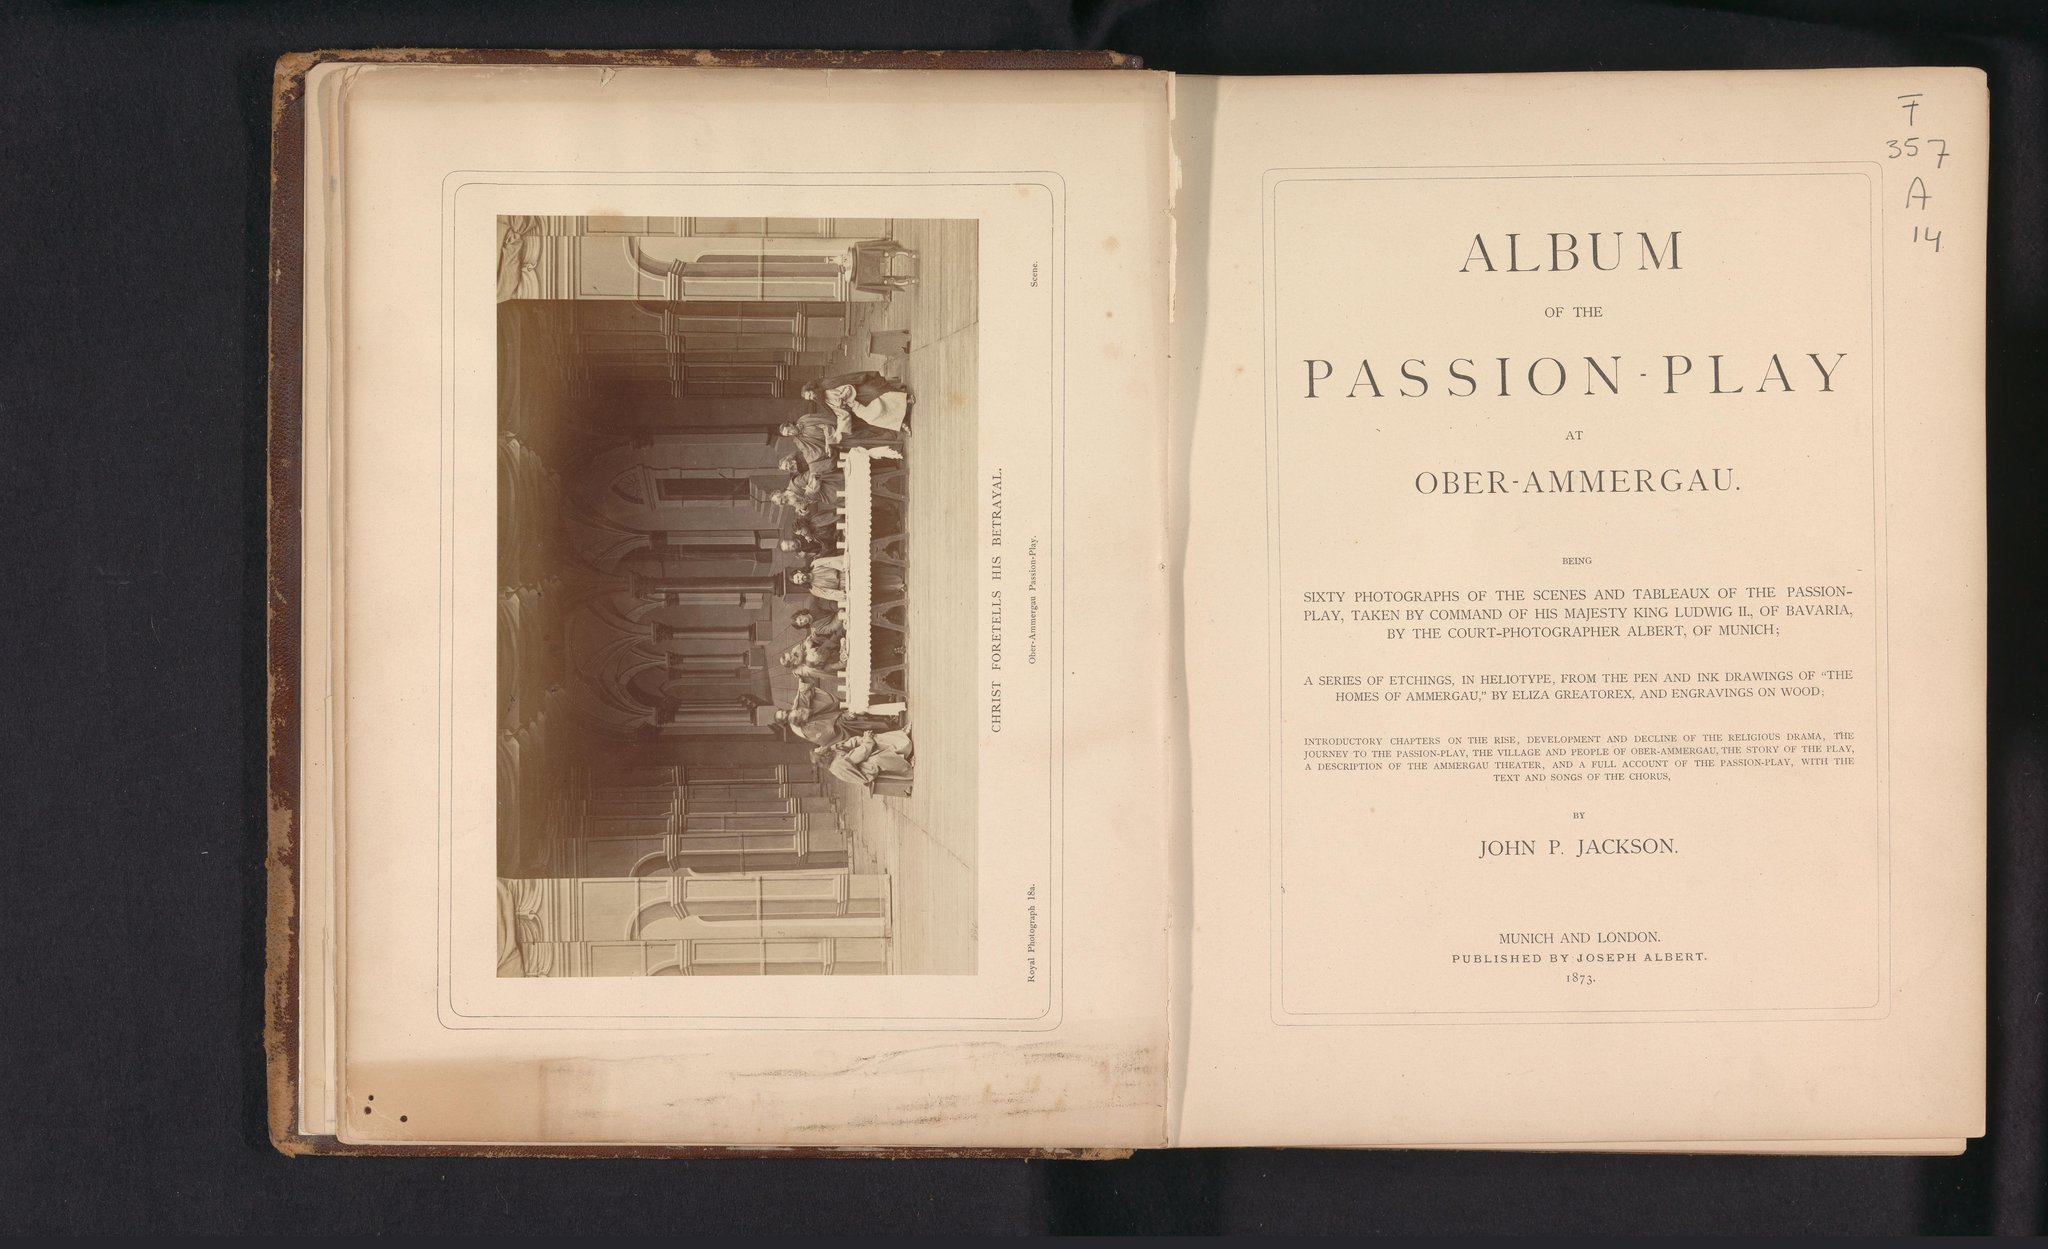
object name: photograph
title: Christ foretells his betrayal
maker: Anonymous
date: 1868-1873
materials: photographic support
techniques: albumen print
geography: oberammergau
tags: judas iscariot is revealed as christ's betrayer (communion of judas), group of actors, troupe; actors on the stage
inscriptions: inscription: ‘Royal Photograph 18a.’